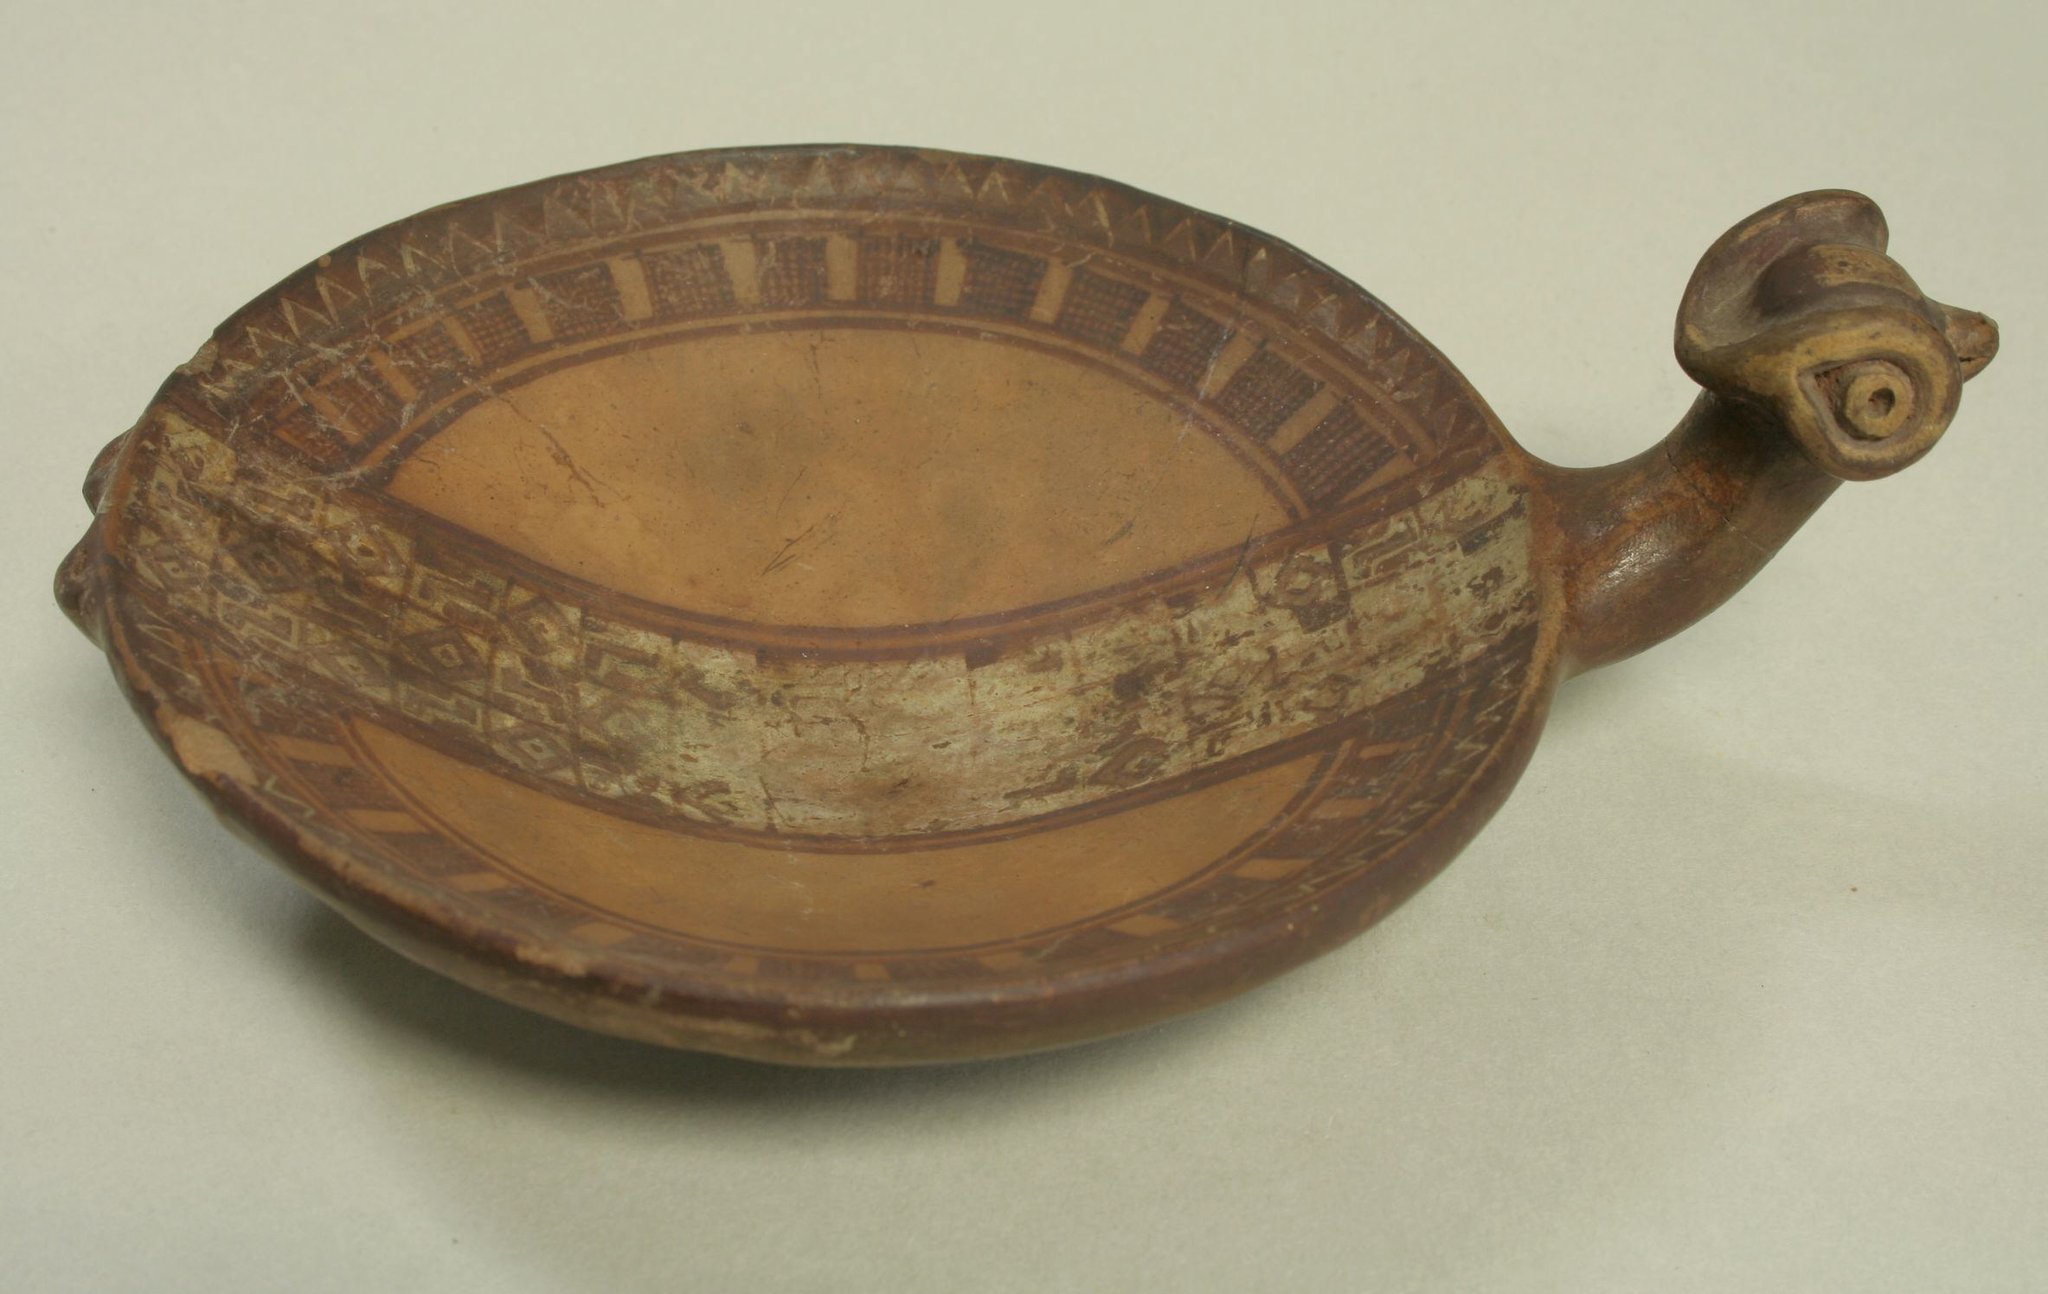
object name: dish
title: Dish with Bird Head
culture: inca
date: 1401-1600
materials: ceramic, pigment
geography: peru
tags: birds